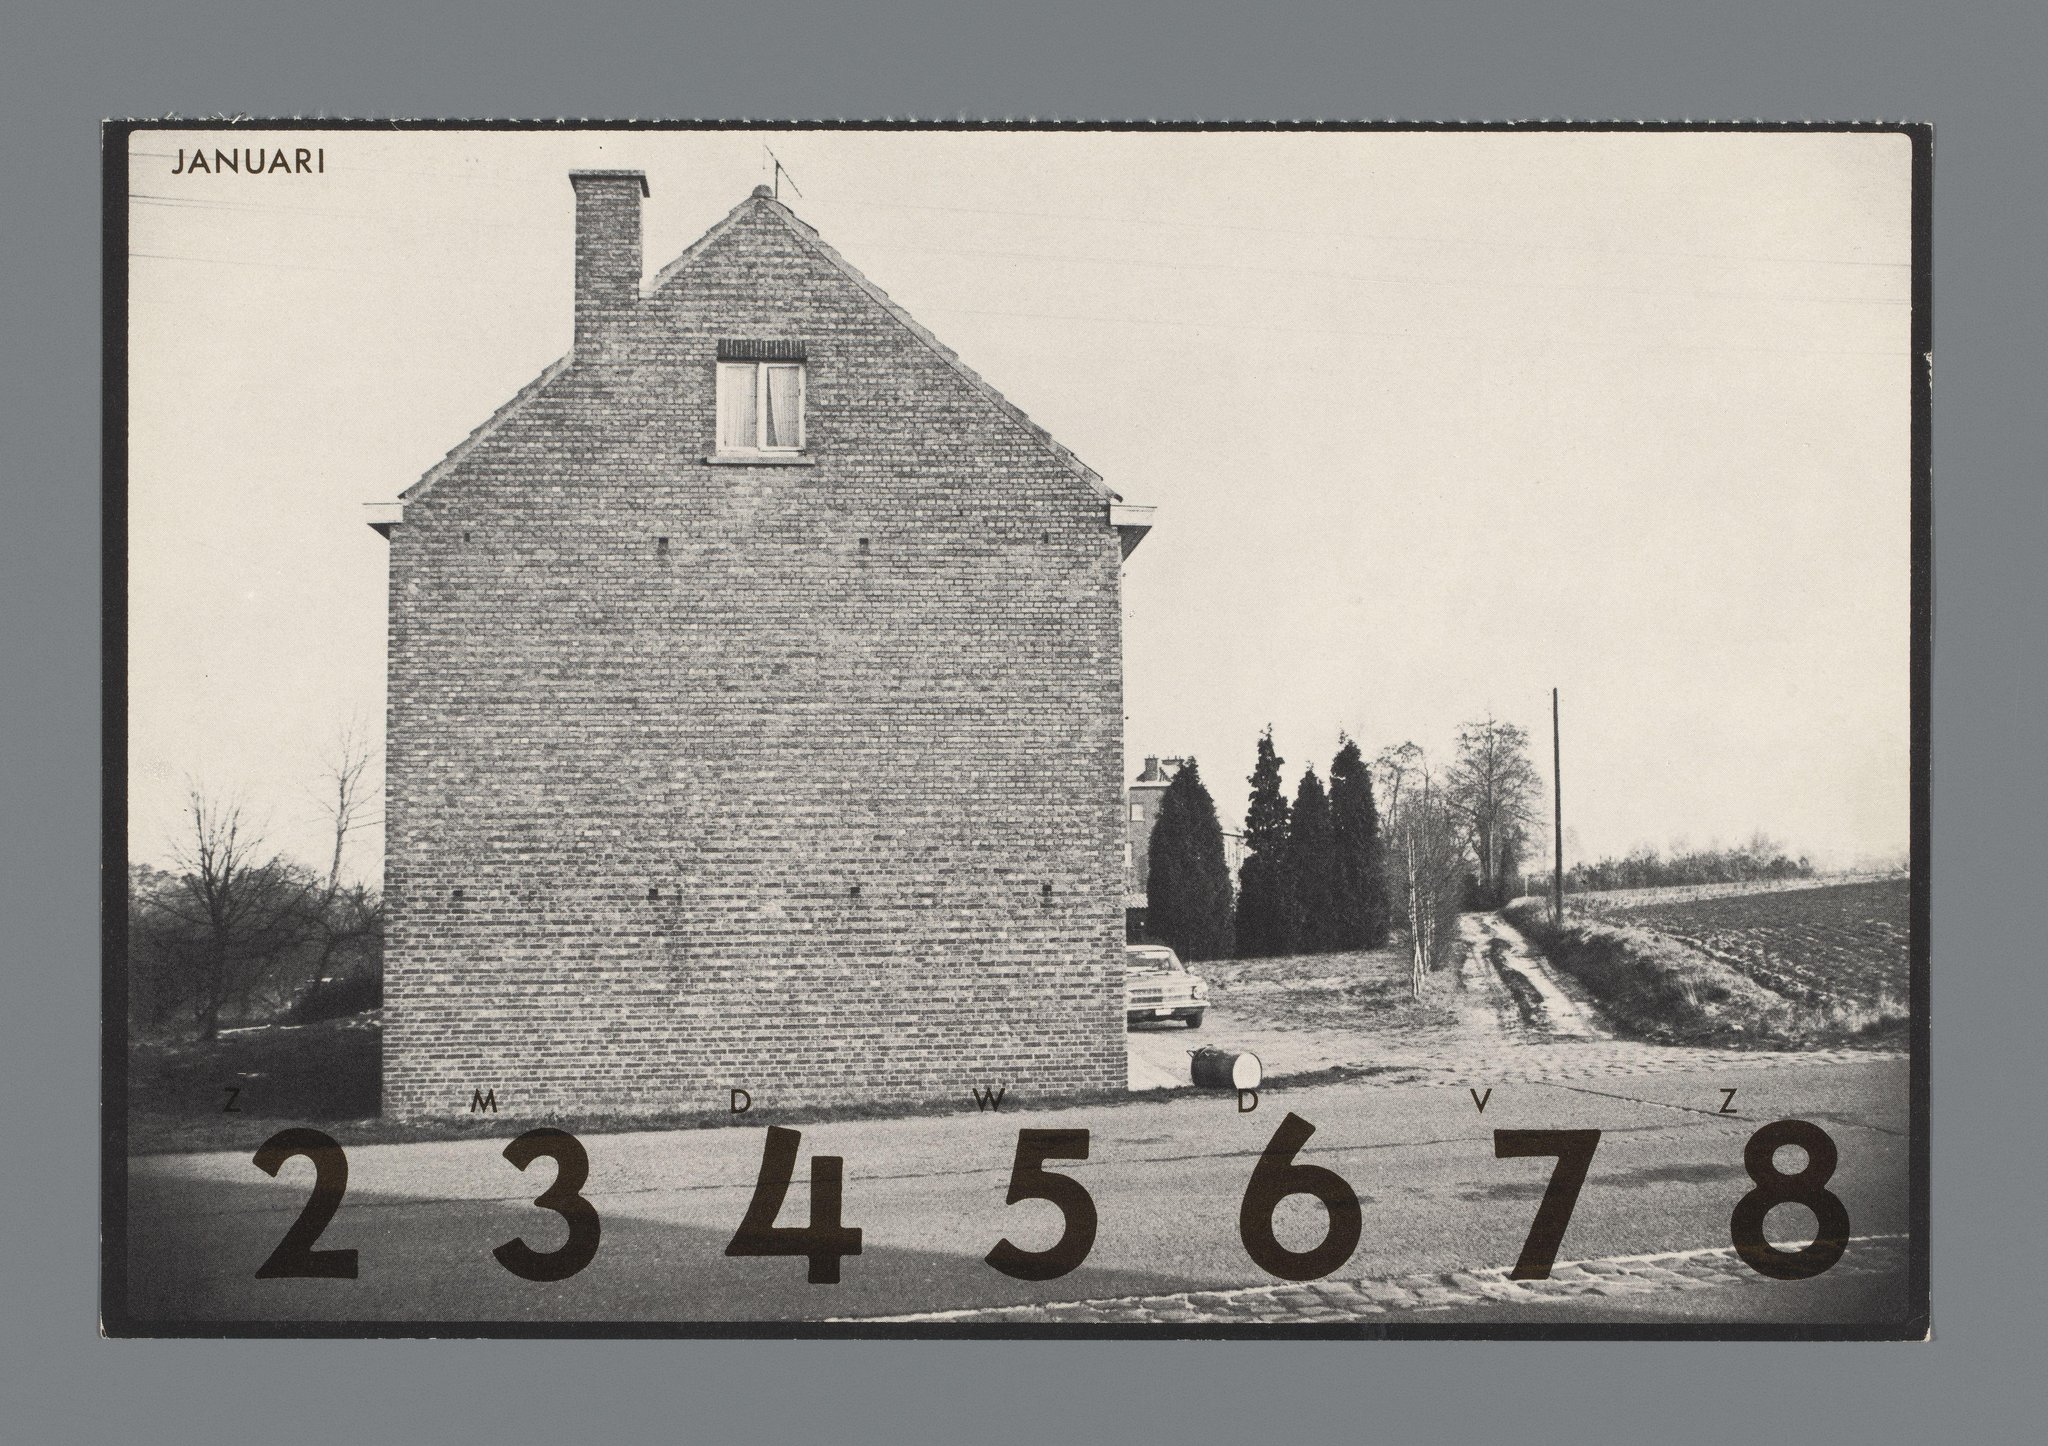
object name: photograph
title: België. Huizen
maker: Anonymous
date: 1900-1950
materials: paper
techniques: offset printed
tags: belgium